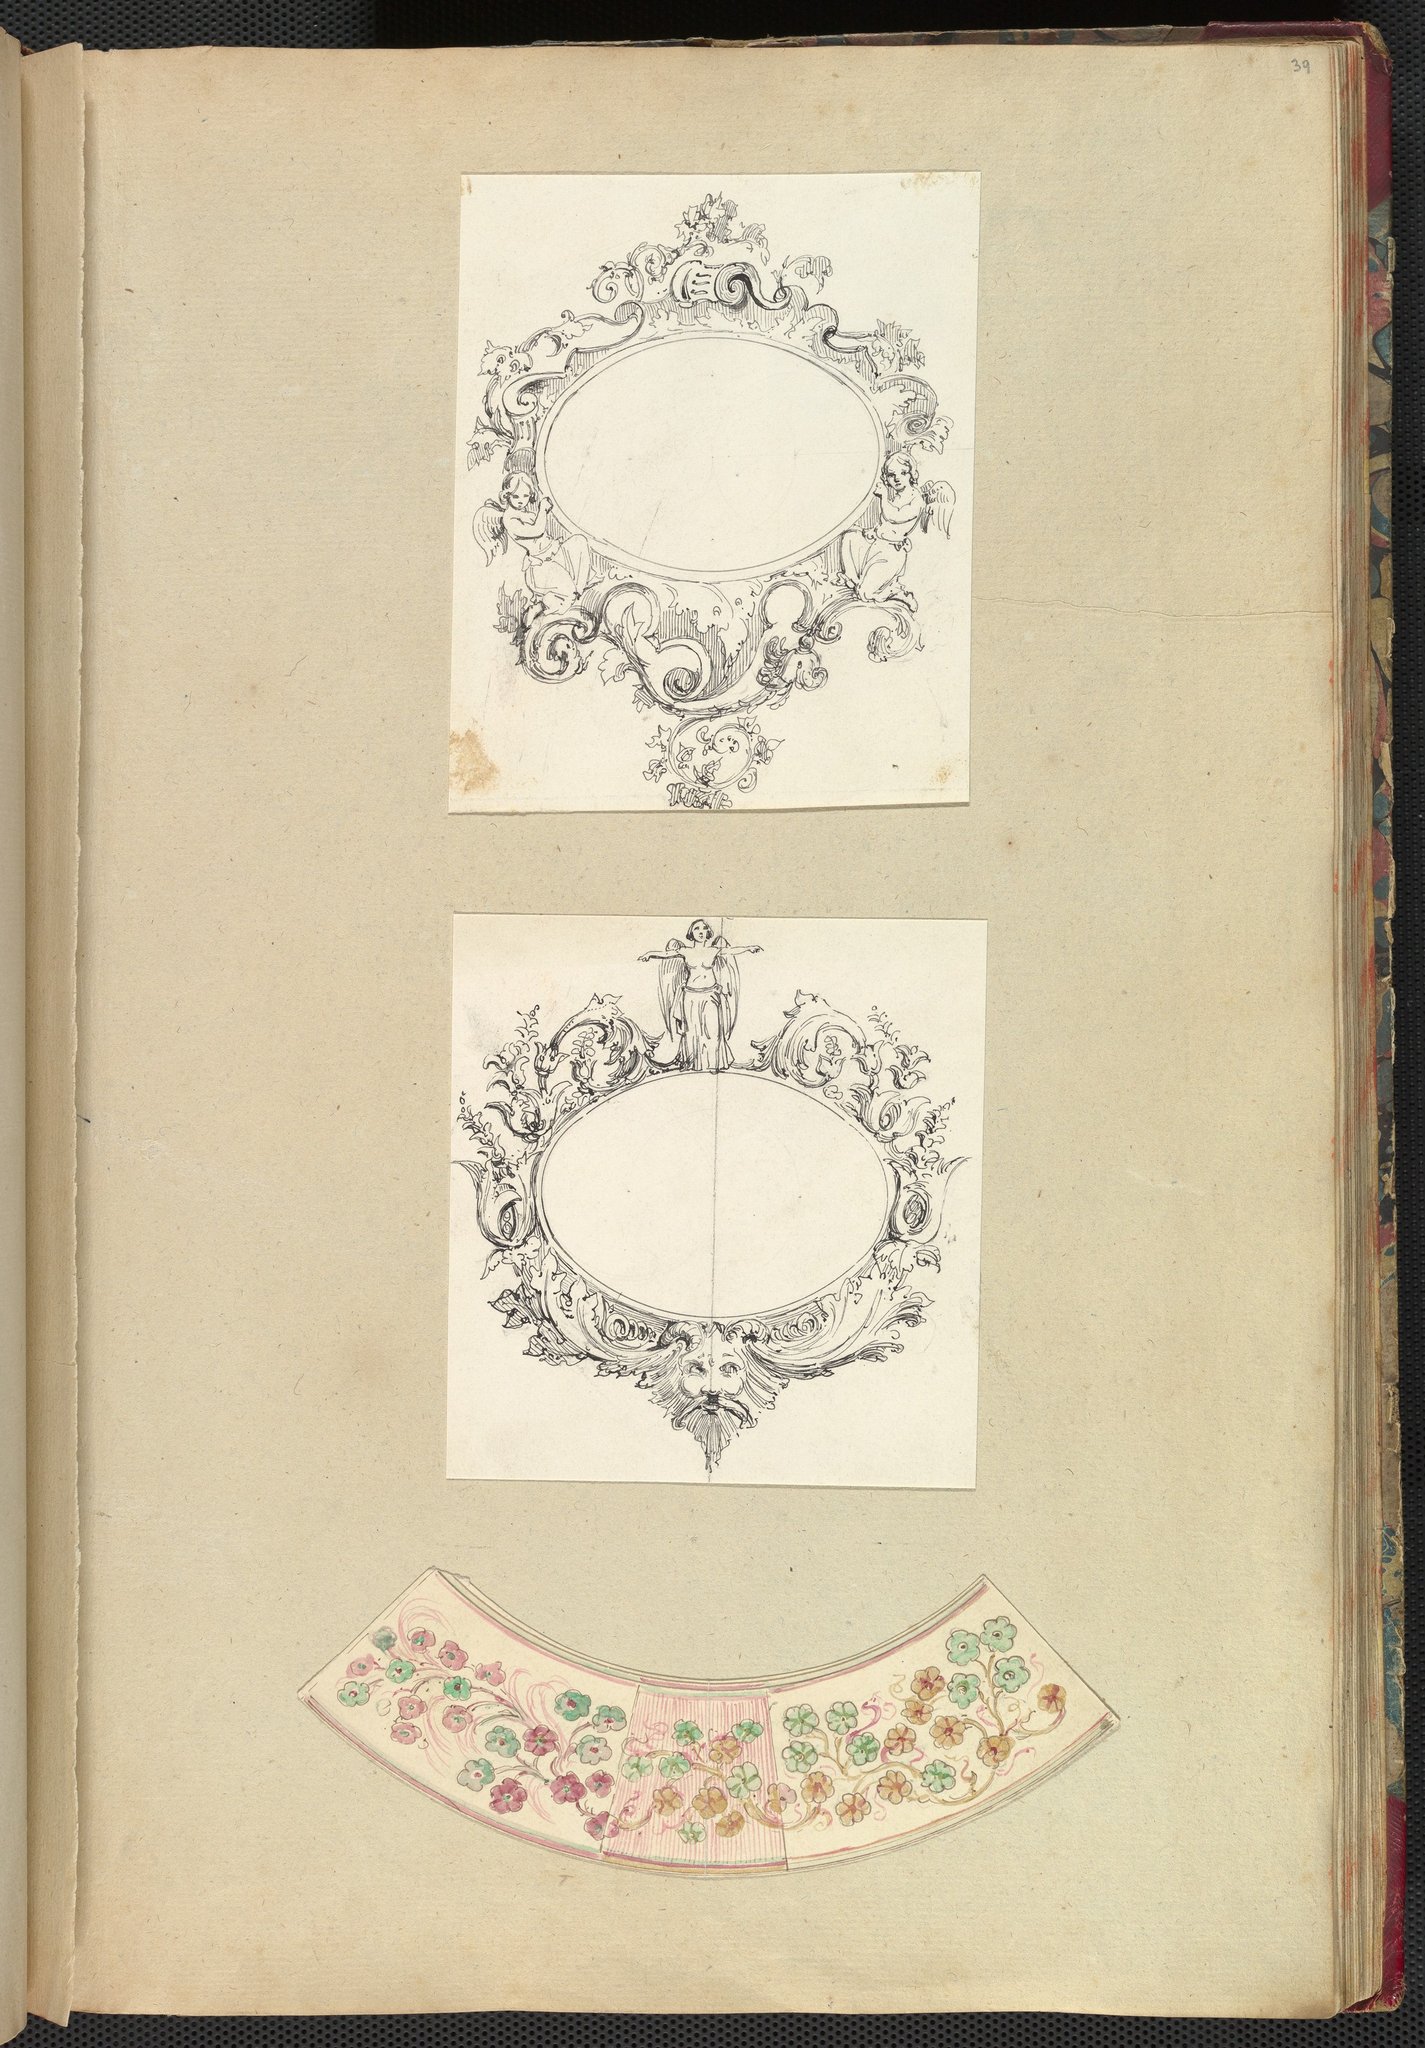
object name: drawing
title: Designs for Two Mirrors and a Plate Rim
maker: alfred henry forrester [alfred crowquill]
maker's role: artist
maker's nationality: british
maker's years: 1804-1872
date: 1845-1855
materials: ink, watercolor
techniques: pen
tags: flowers,mirrors